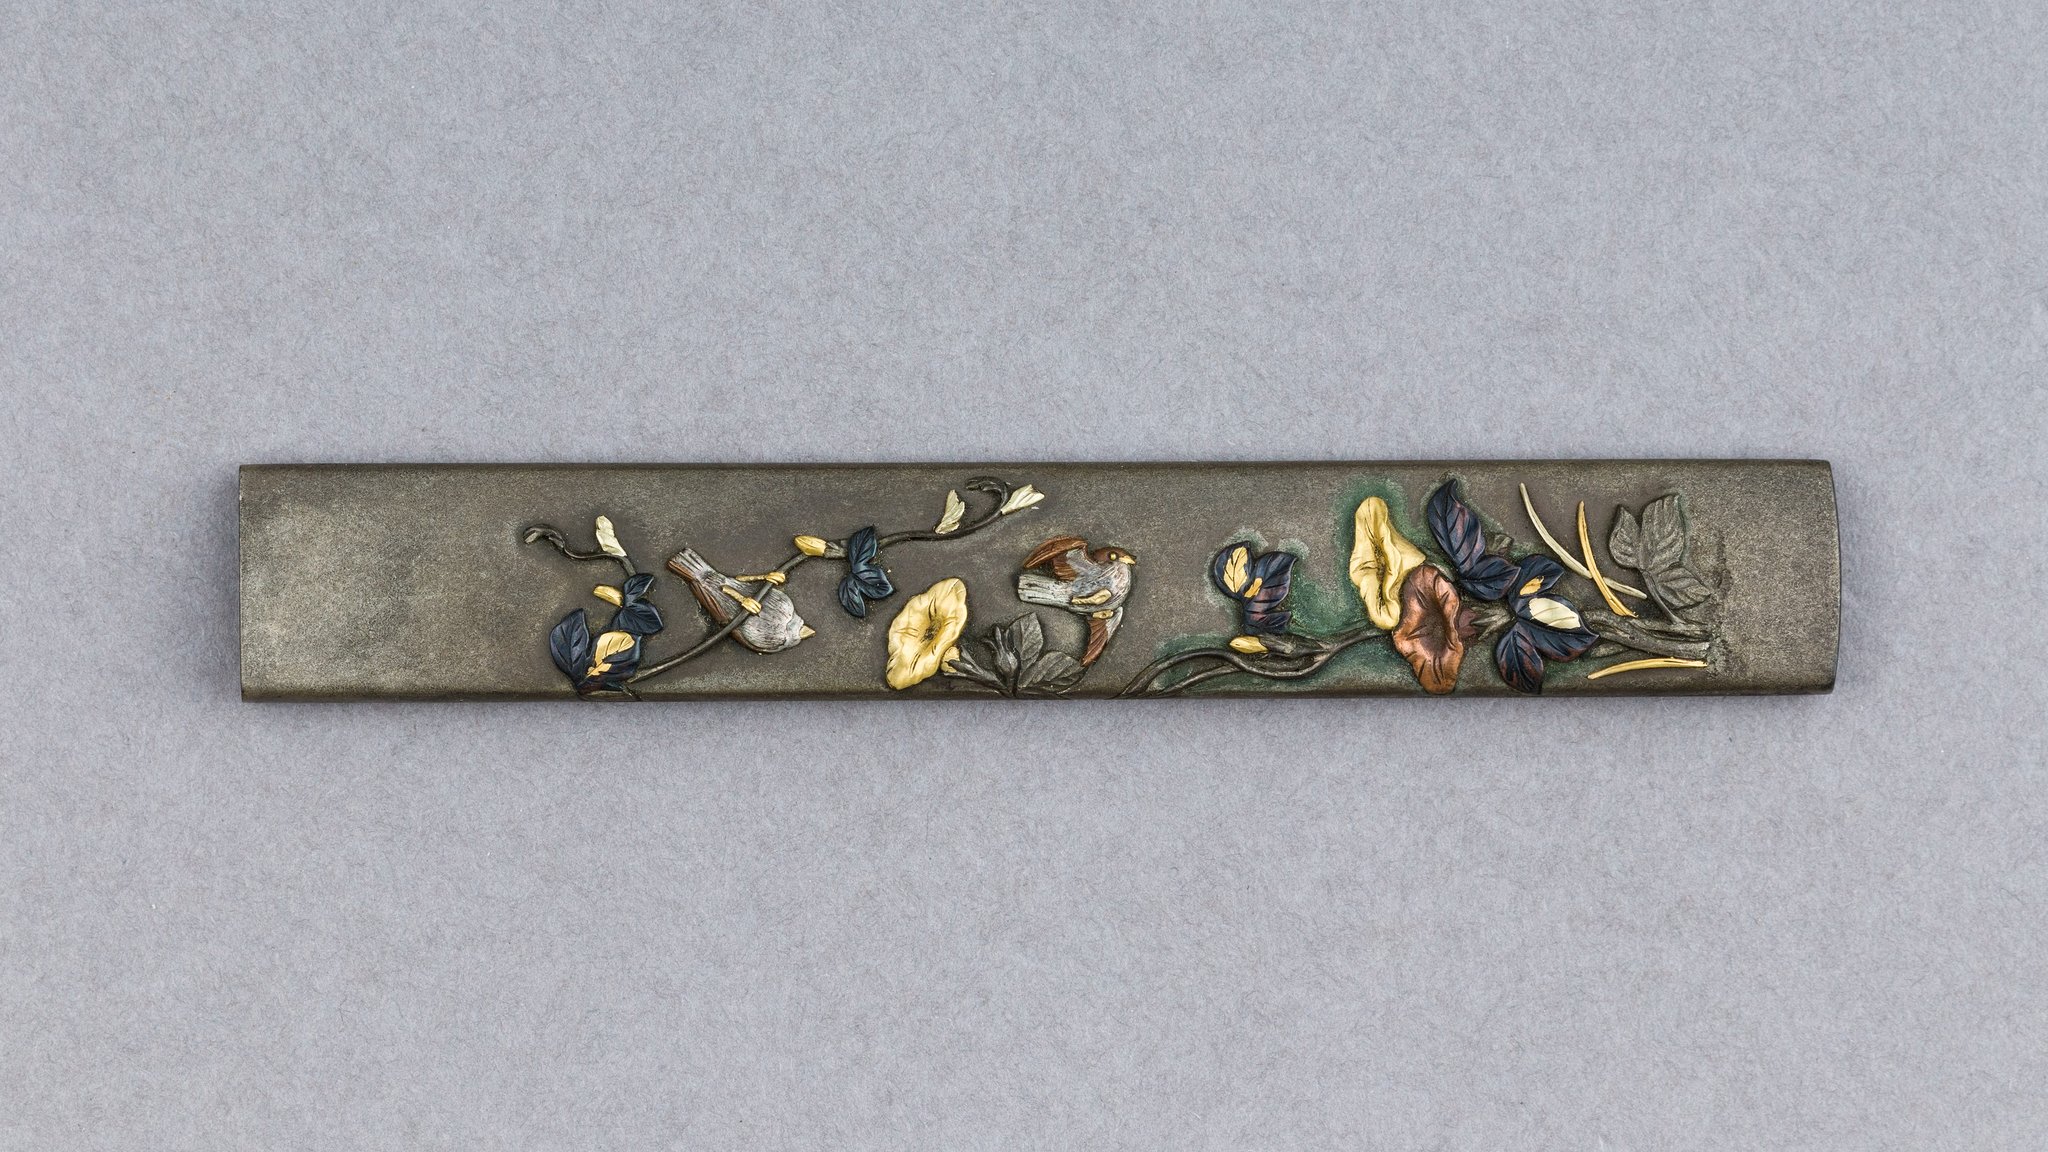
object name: knife handle kozuka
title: Knife Handle (Kozuka)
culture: japanese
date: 1615-1868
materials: copper, gold alloy, silver alloy, gold, silver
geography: japan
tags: birds,flowers